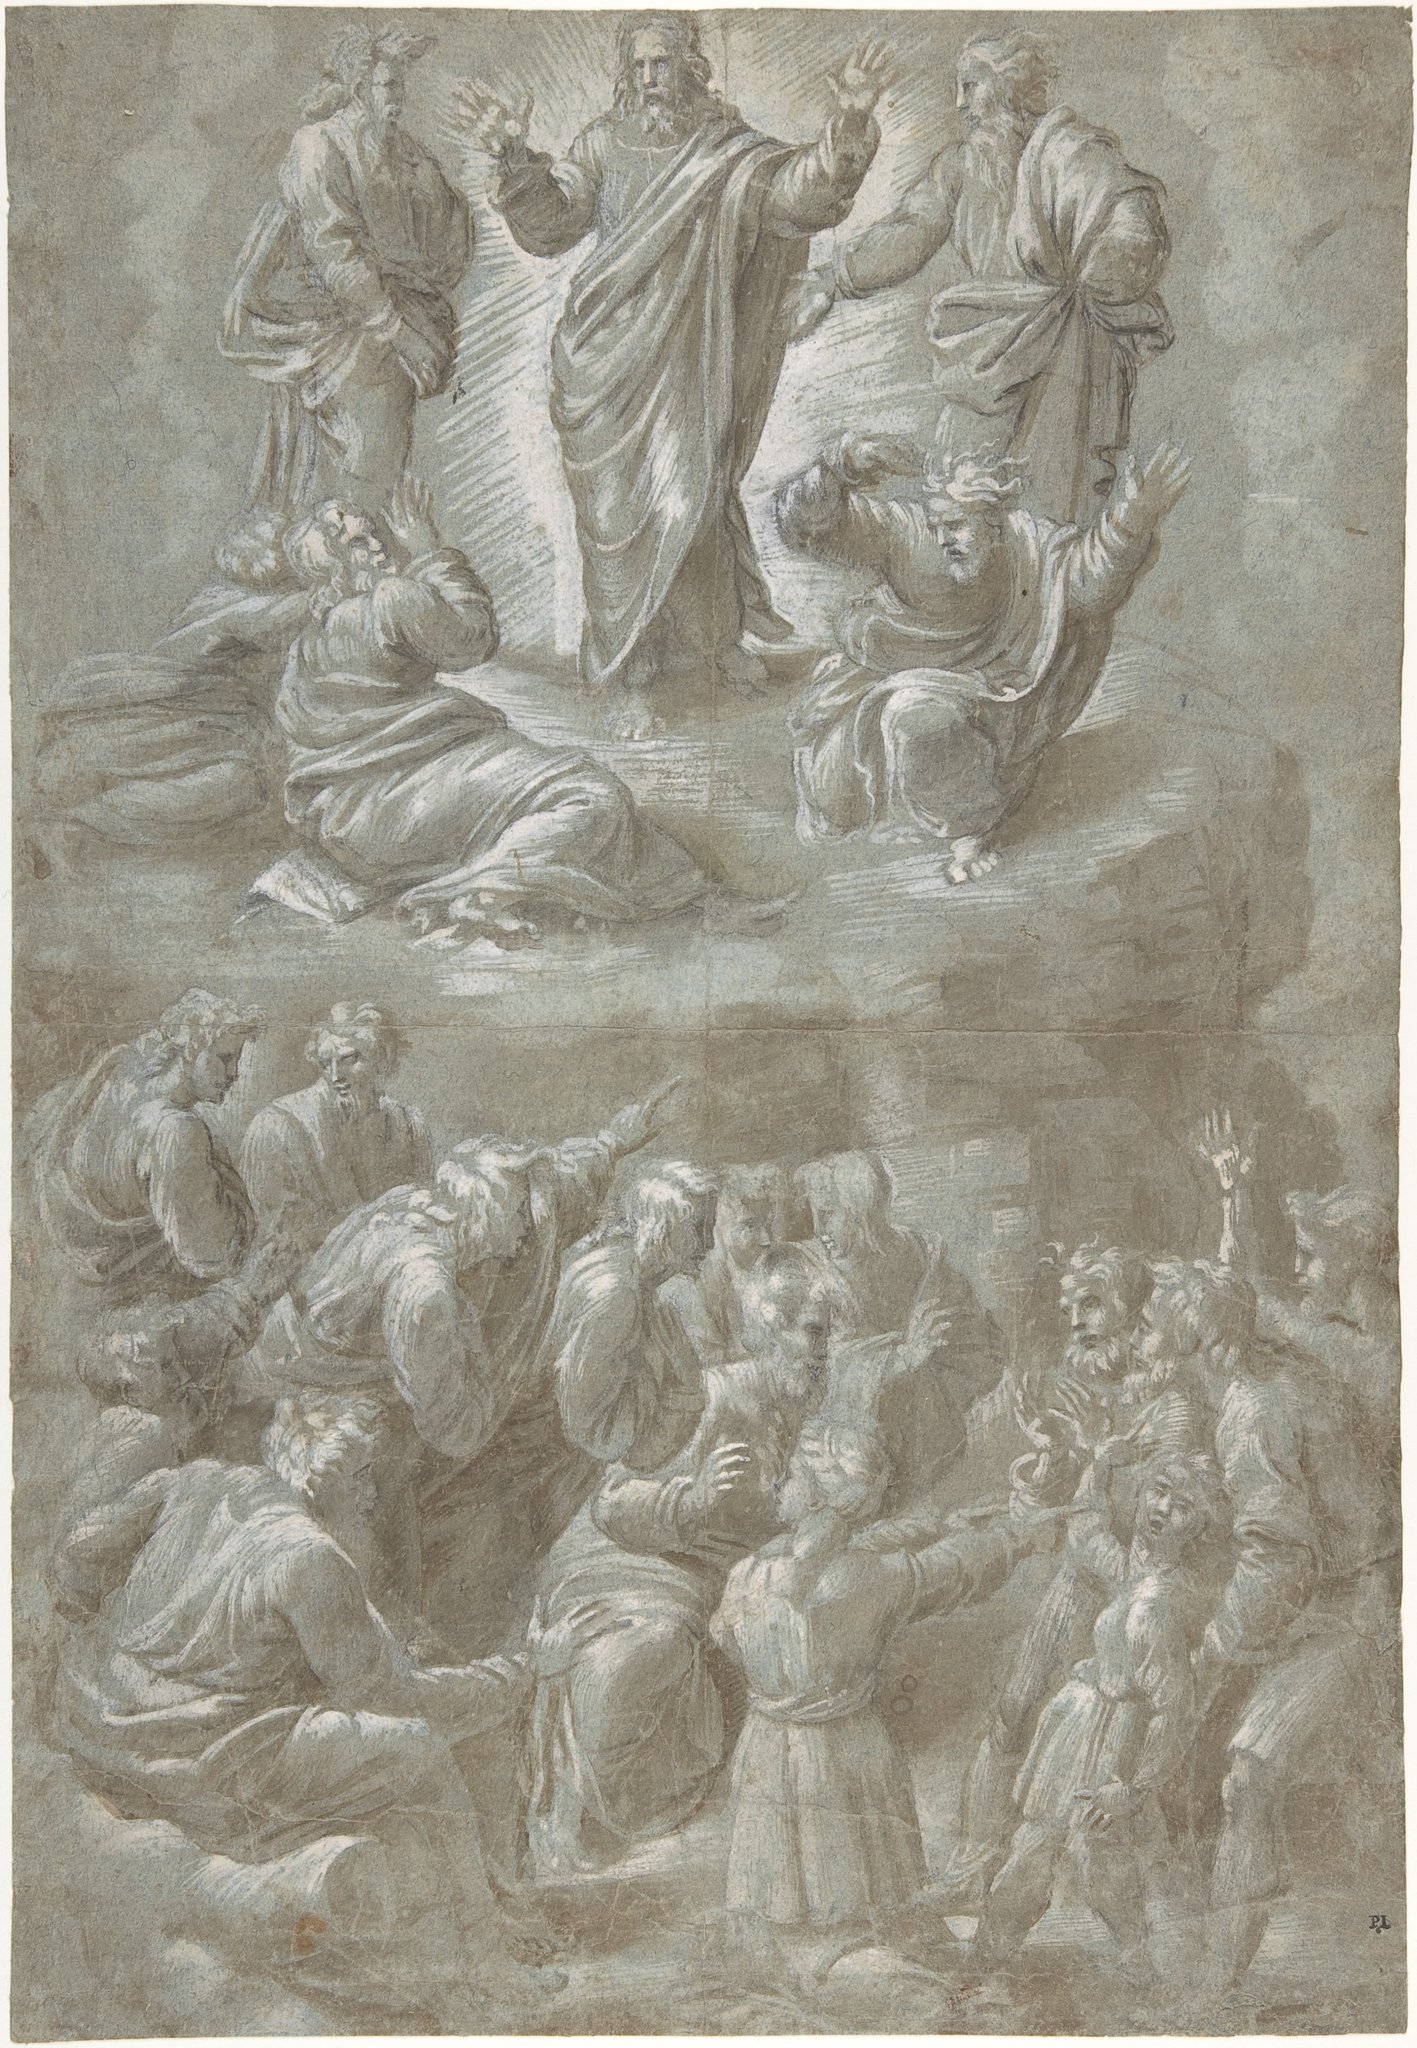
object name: drawing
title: The Transfiguration, after Raphael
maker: biagio pupini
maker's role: artist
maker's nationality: italian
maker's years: 1511-1551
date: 1511-1551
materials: charcoal, gouache, paper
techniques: brush, highlighting, wash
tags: men,christ